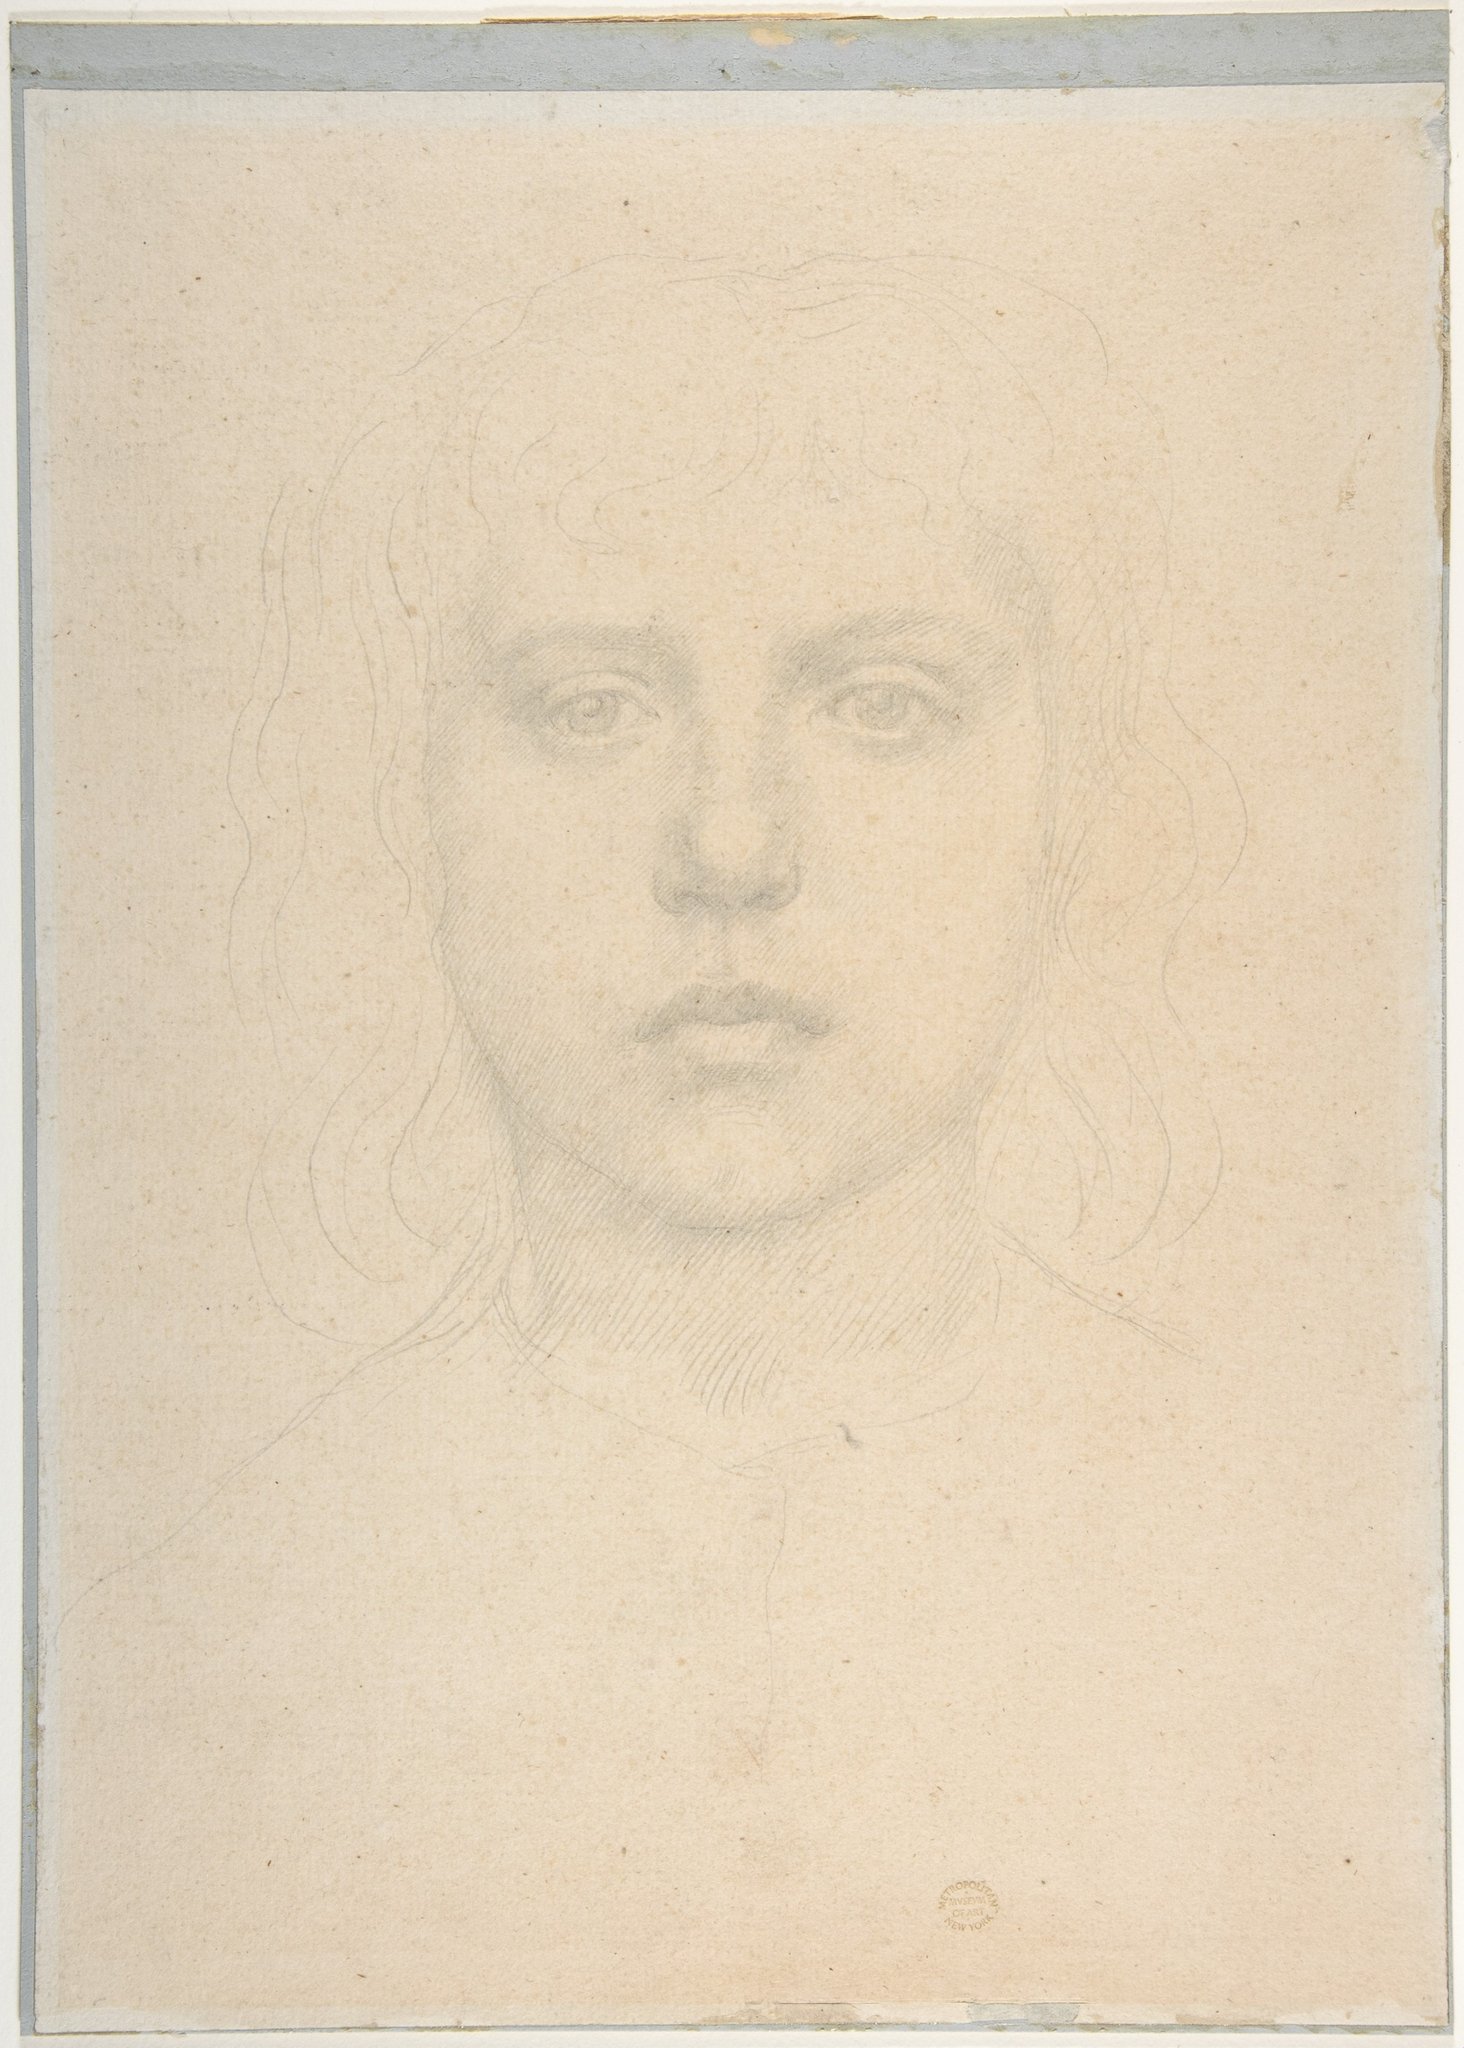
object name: drawing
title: Head of a Girl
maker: alphonse legros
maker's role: artist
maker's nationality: french and british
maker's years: 1837-1911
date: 1837-1911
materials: graphite, paper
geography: france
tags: faces,heads,girls,portraits